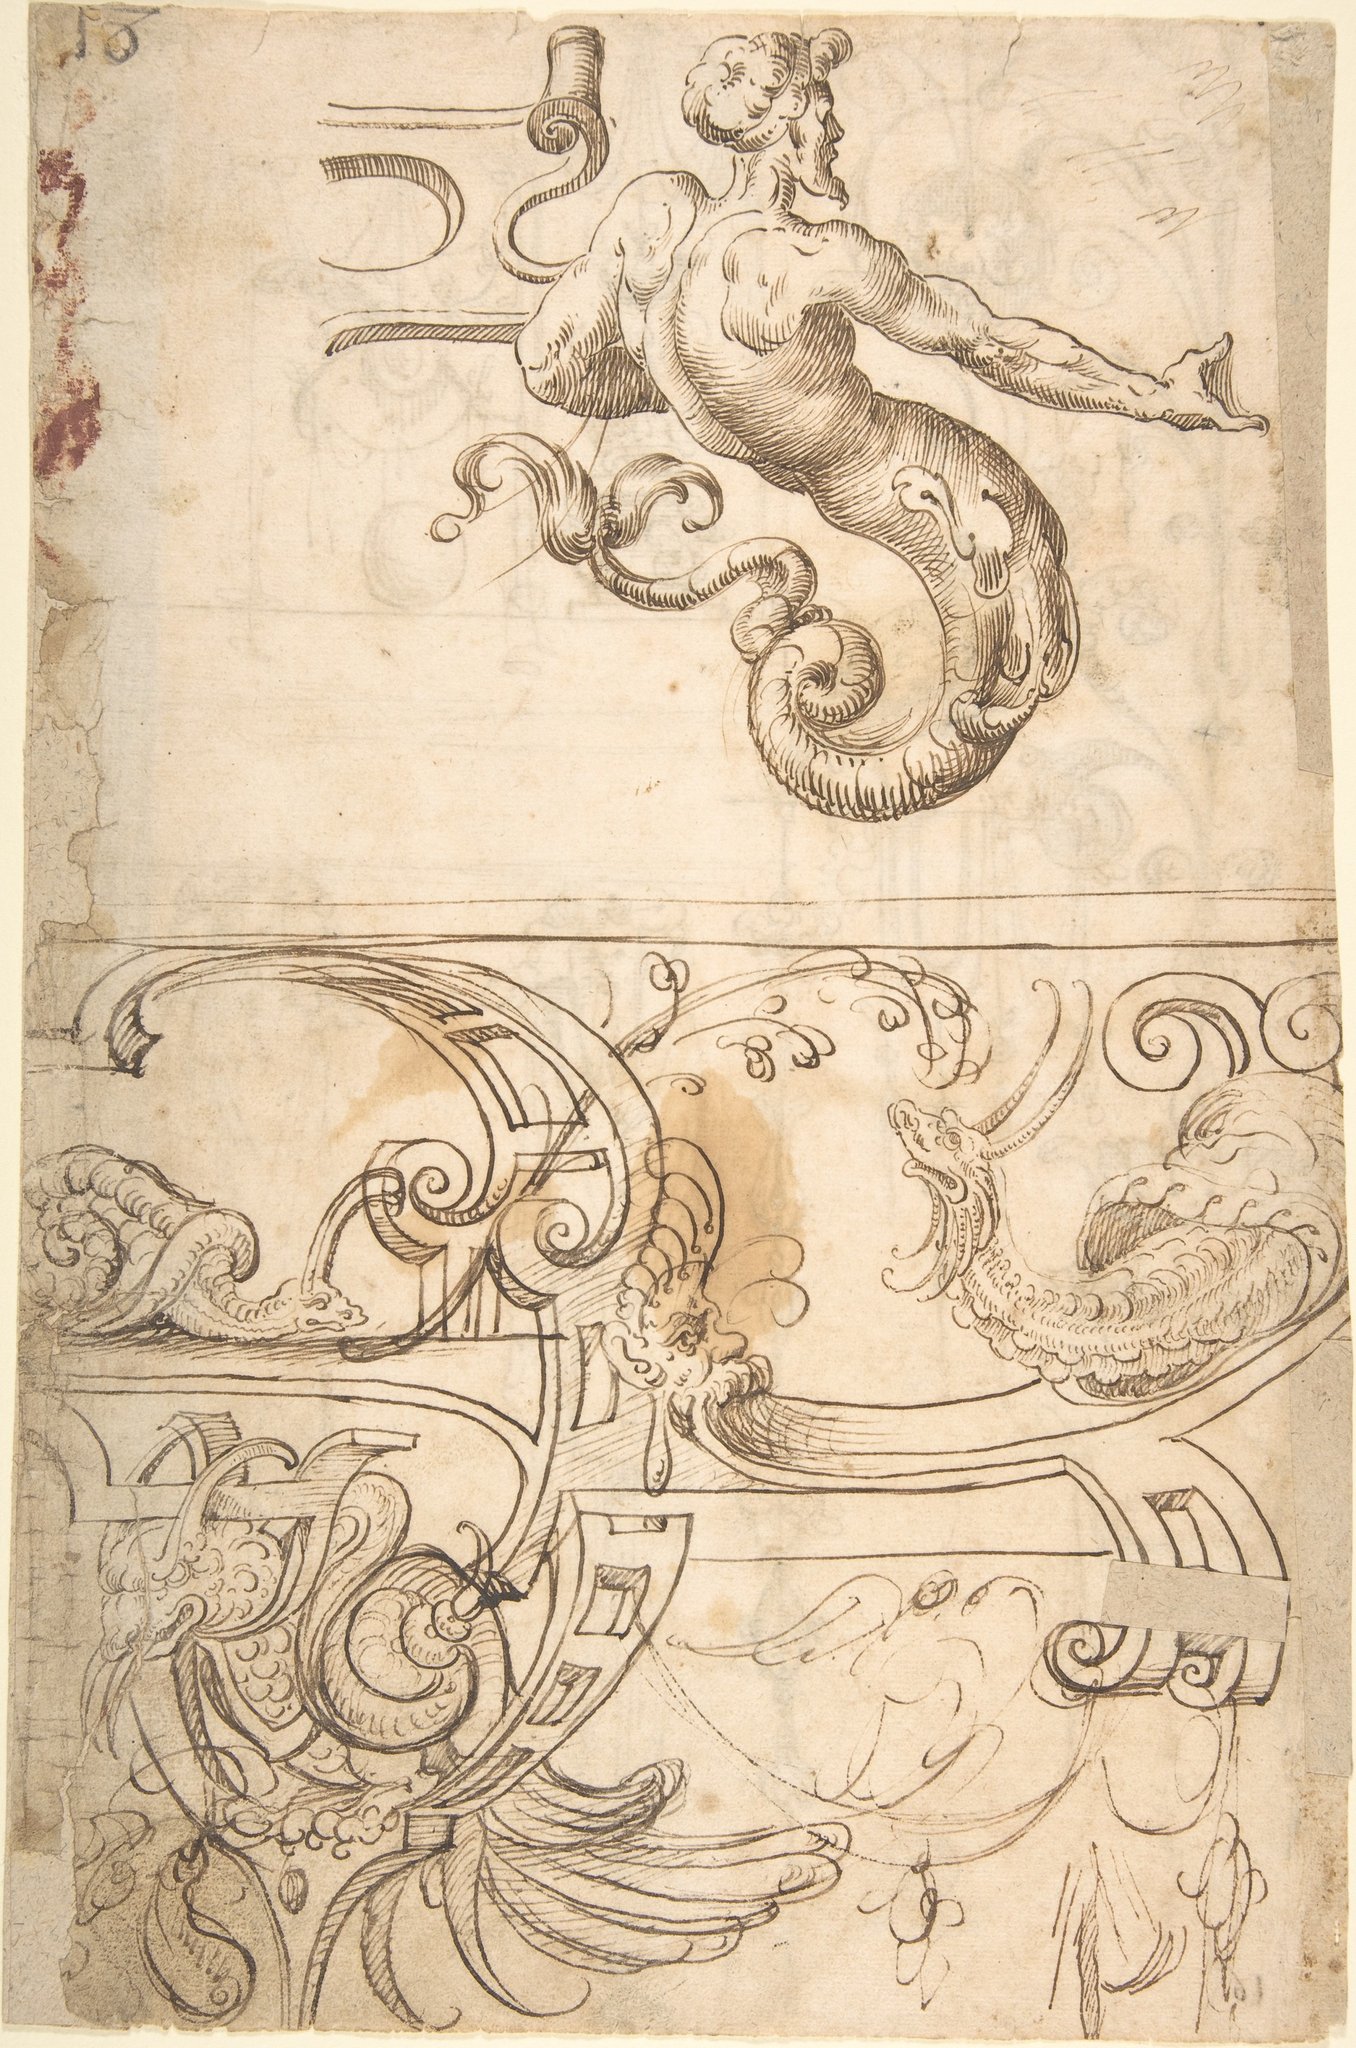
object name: drawing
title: Various Designs of Strapwork and Grotesque Figures (recto); Grotesques with Term Figures (verso)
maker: andrés de melgar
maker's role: artist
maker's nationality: spanish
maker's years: 1554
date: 1545-1560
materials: ink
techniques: pen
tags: grotesques,ornament,mythical creatures